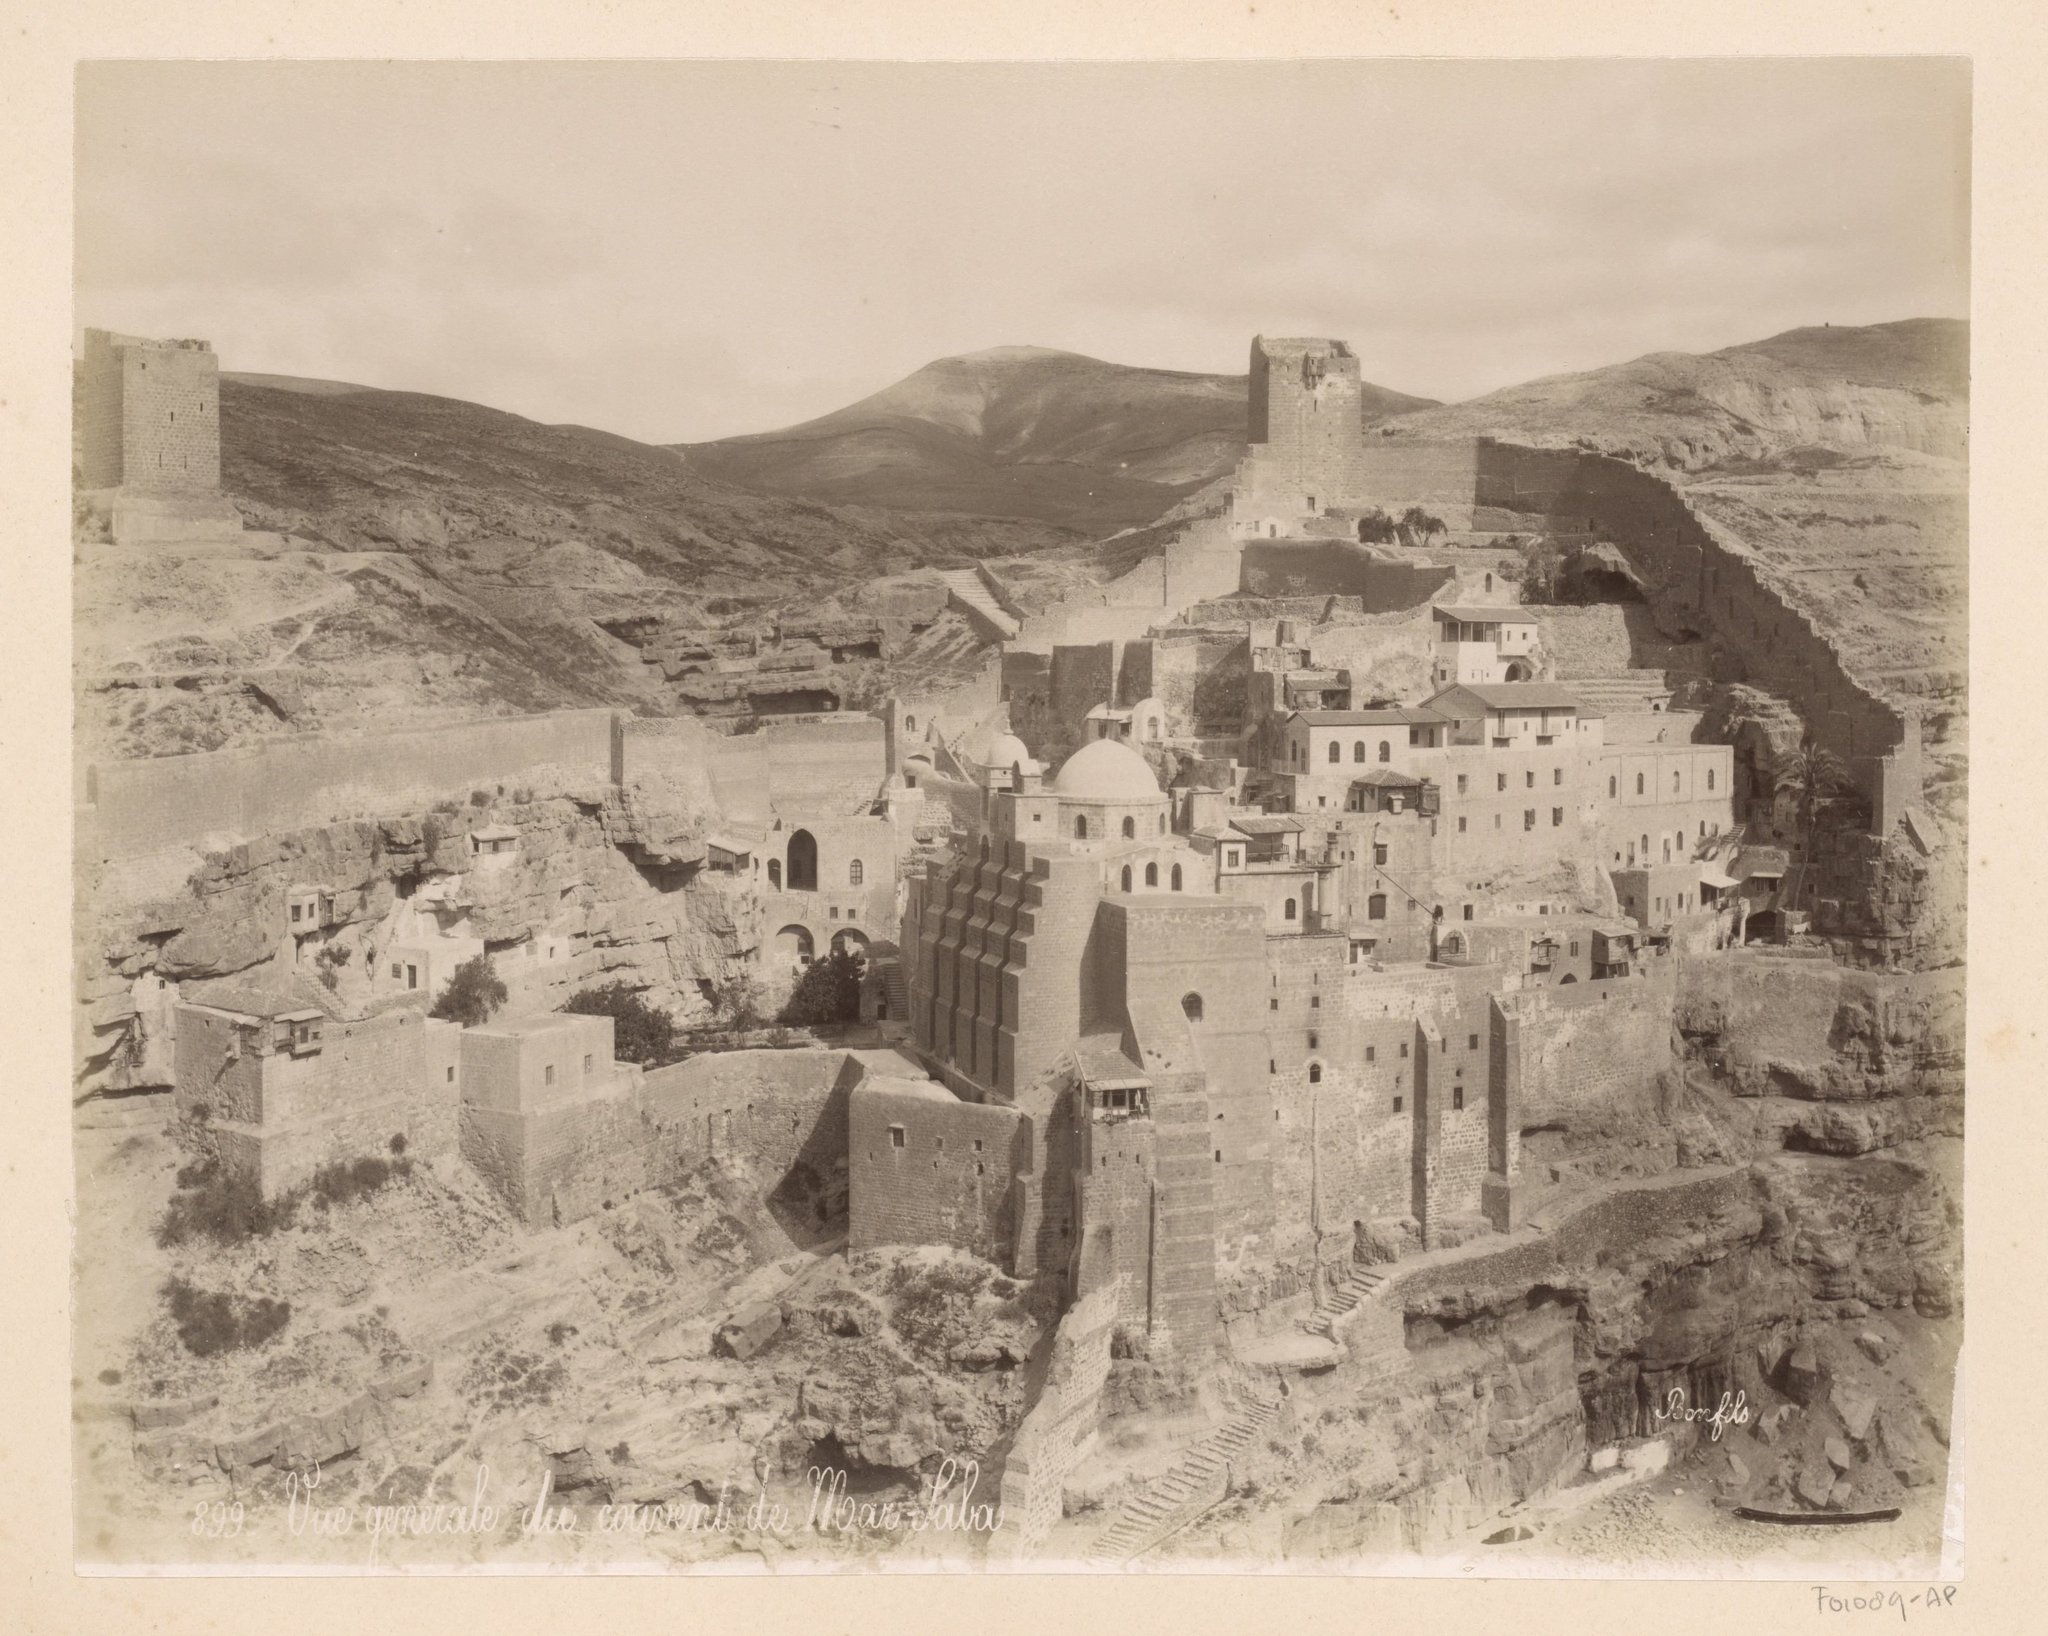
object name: photograph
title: Gezicht op het klooster van Mar Saba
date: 1867-1895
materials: cardboard, paper, photographic support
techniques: albumen print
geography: mar saba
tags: monastic orders, monastic life ~ eastern, greek and russian orthodox churches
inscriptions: negative number: ‘899’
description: Onderdeel van Reisalbum met foto's van Jeruzalem en andere bijbelse plaatsen.